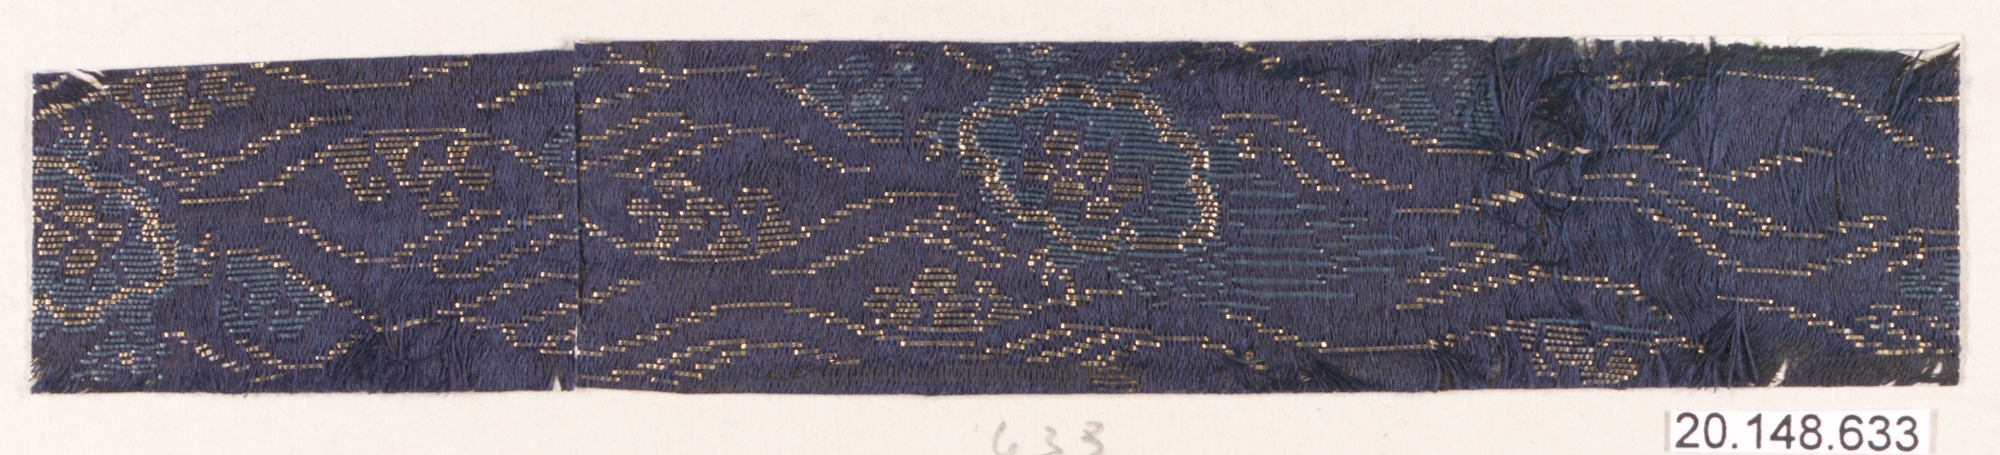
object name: piece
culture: japanese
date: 1701-1800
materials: silk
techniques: compound weave